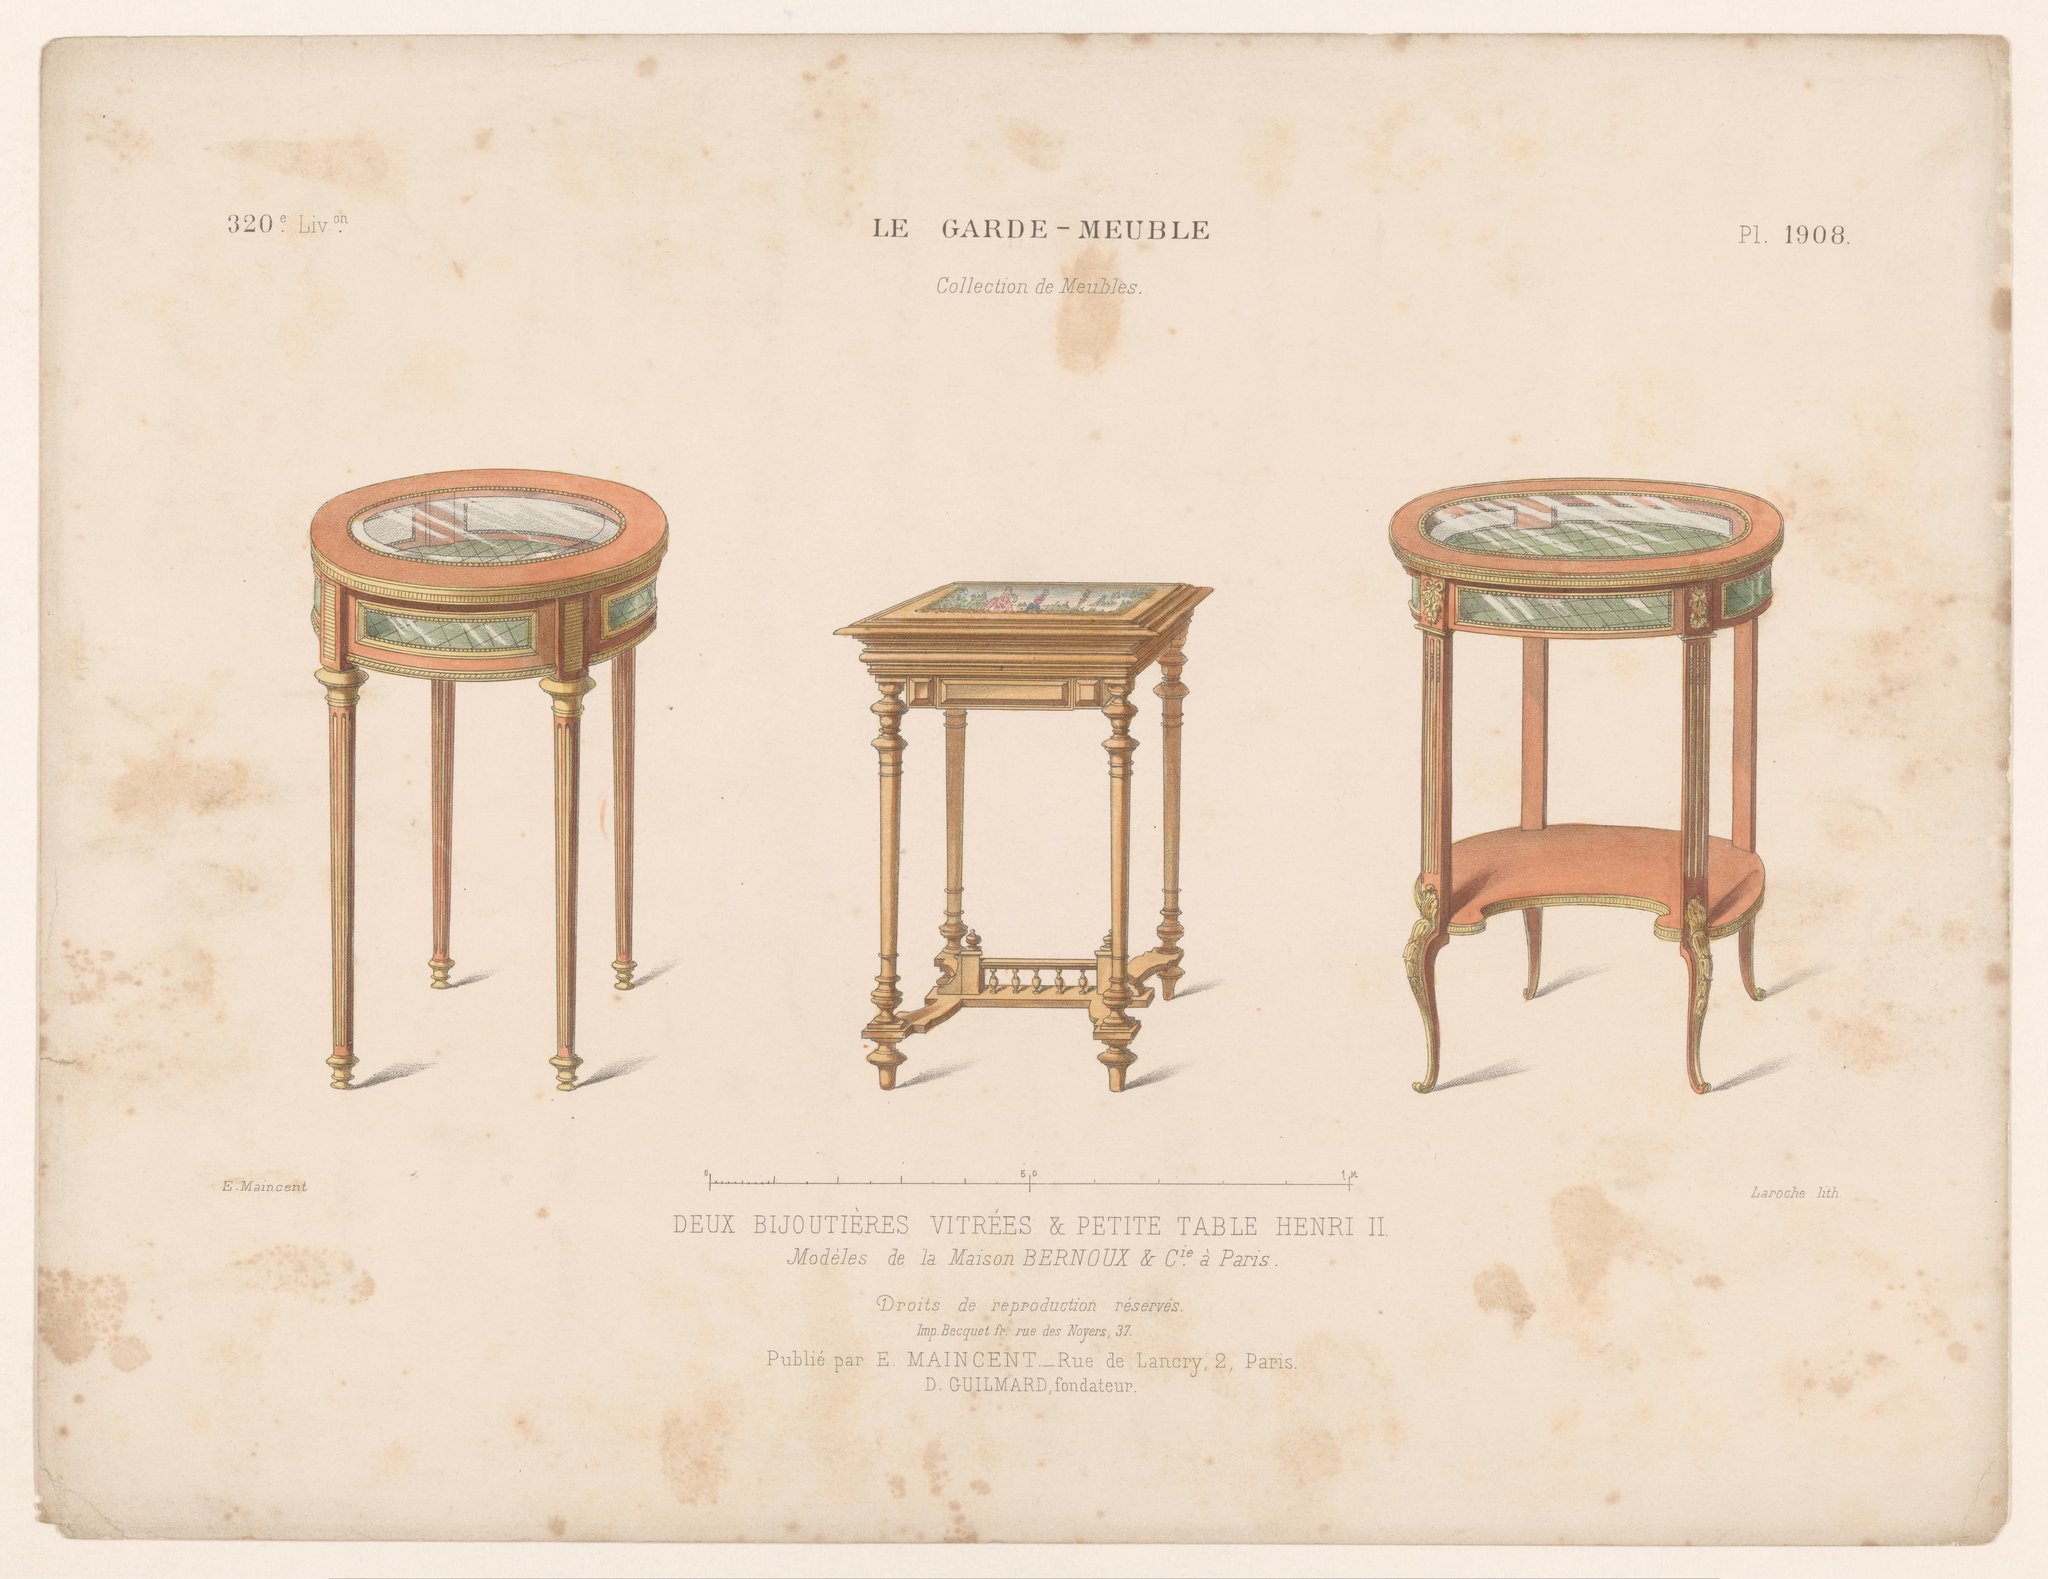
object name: print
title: Drie bijzettafels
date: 1885-1895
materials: paper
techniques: hand coloring, lithograph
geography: paris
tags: table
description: Ieder Livraison in de serie Le Garde-Meuble bevat negen platen: drie 'sièges' (zitmeubels), drie 'meubles' (diverse meubels zoals tafels en kasten) en drie 'tentures' (gordijnen en draperieën).